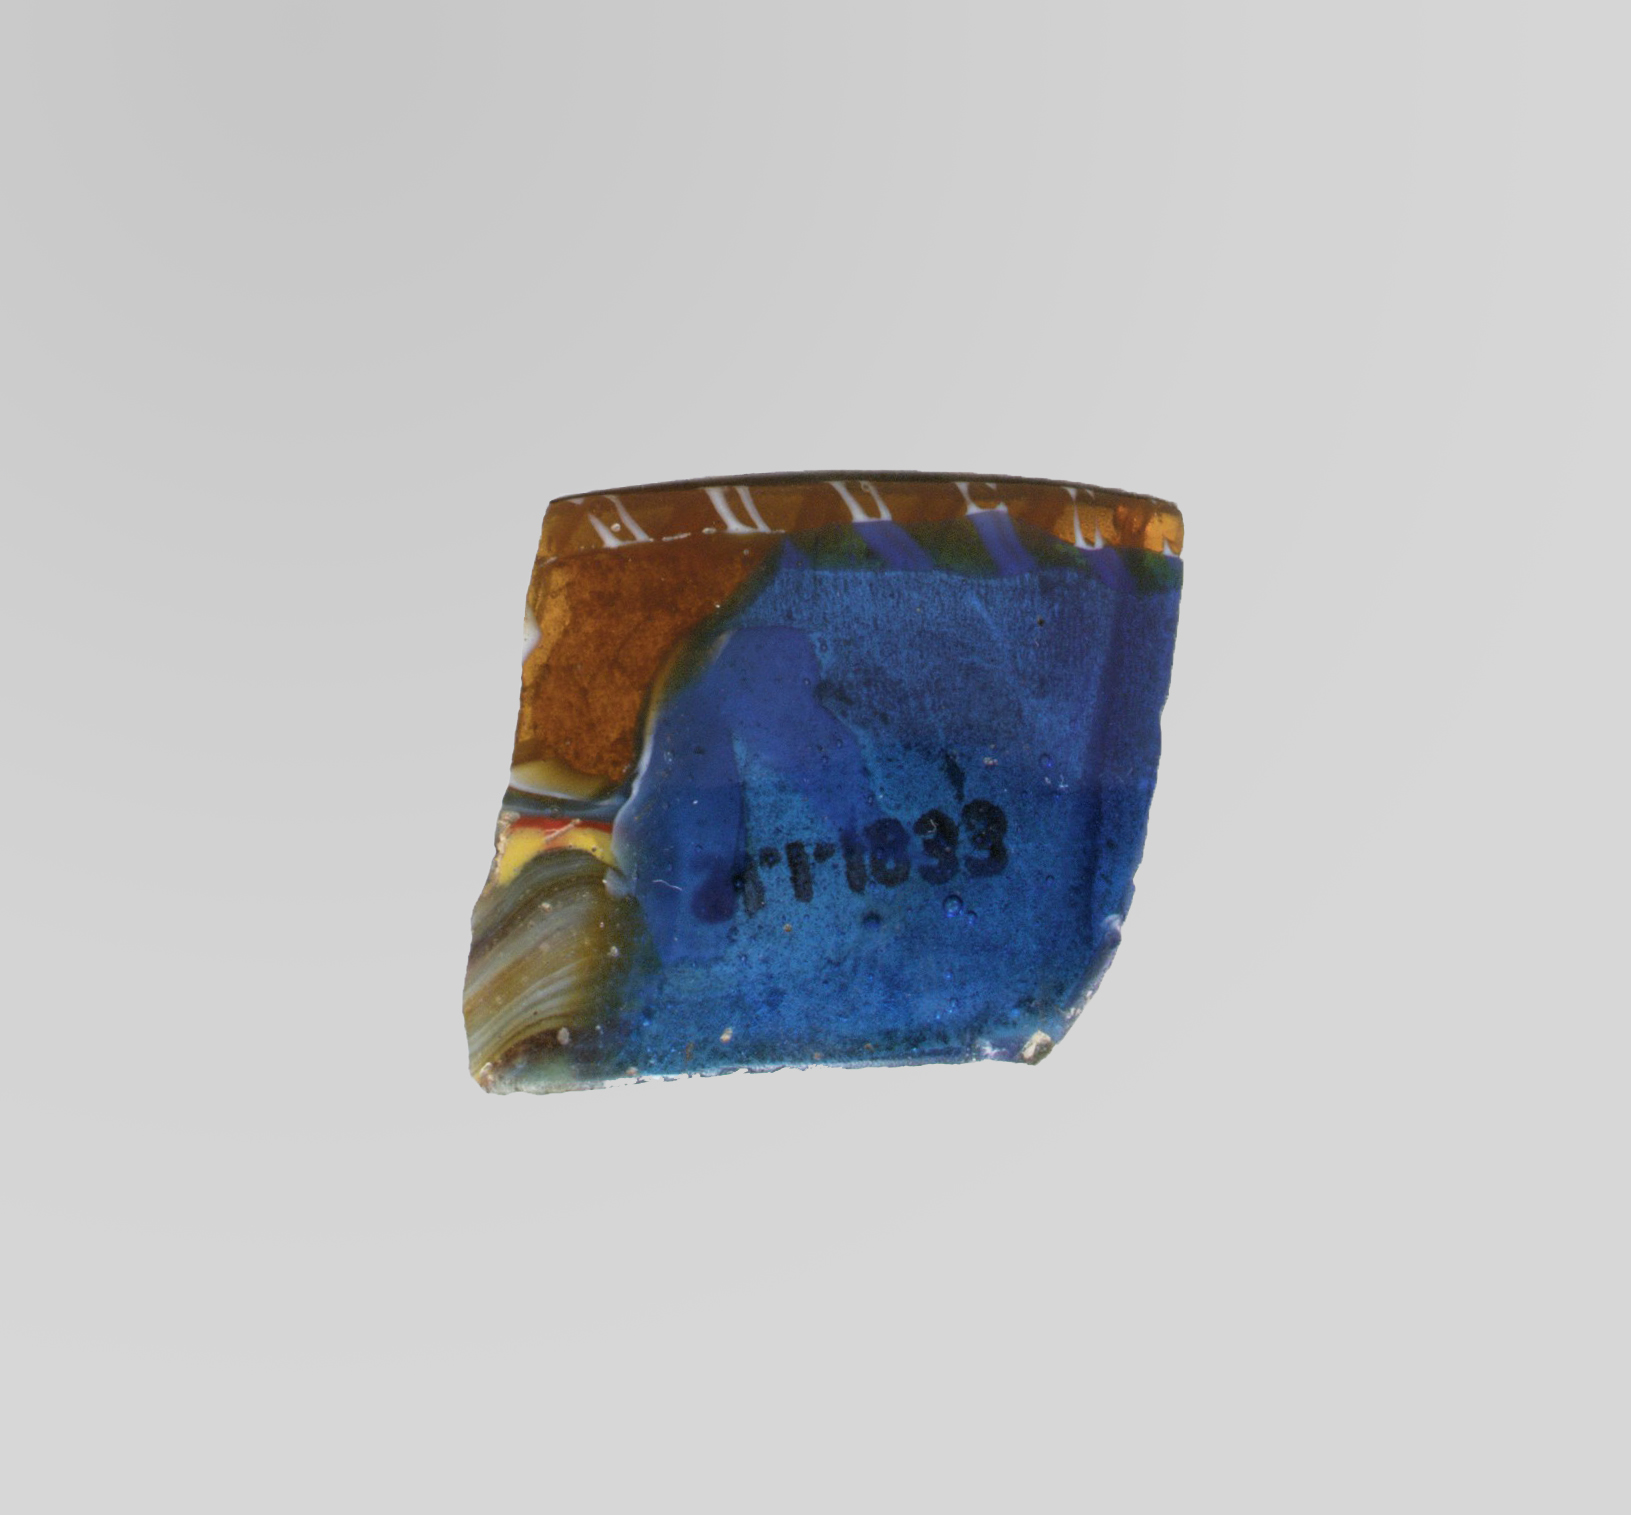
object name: fragment, mosaic bowl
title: Glass short-strip mosaic bowl fragment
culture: roman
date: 34 BCE-33 CE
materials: glass